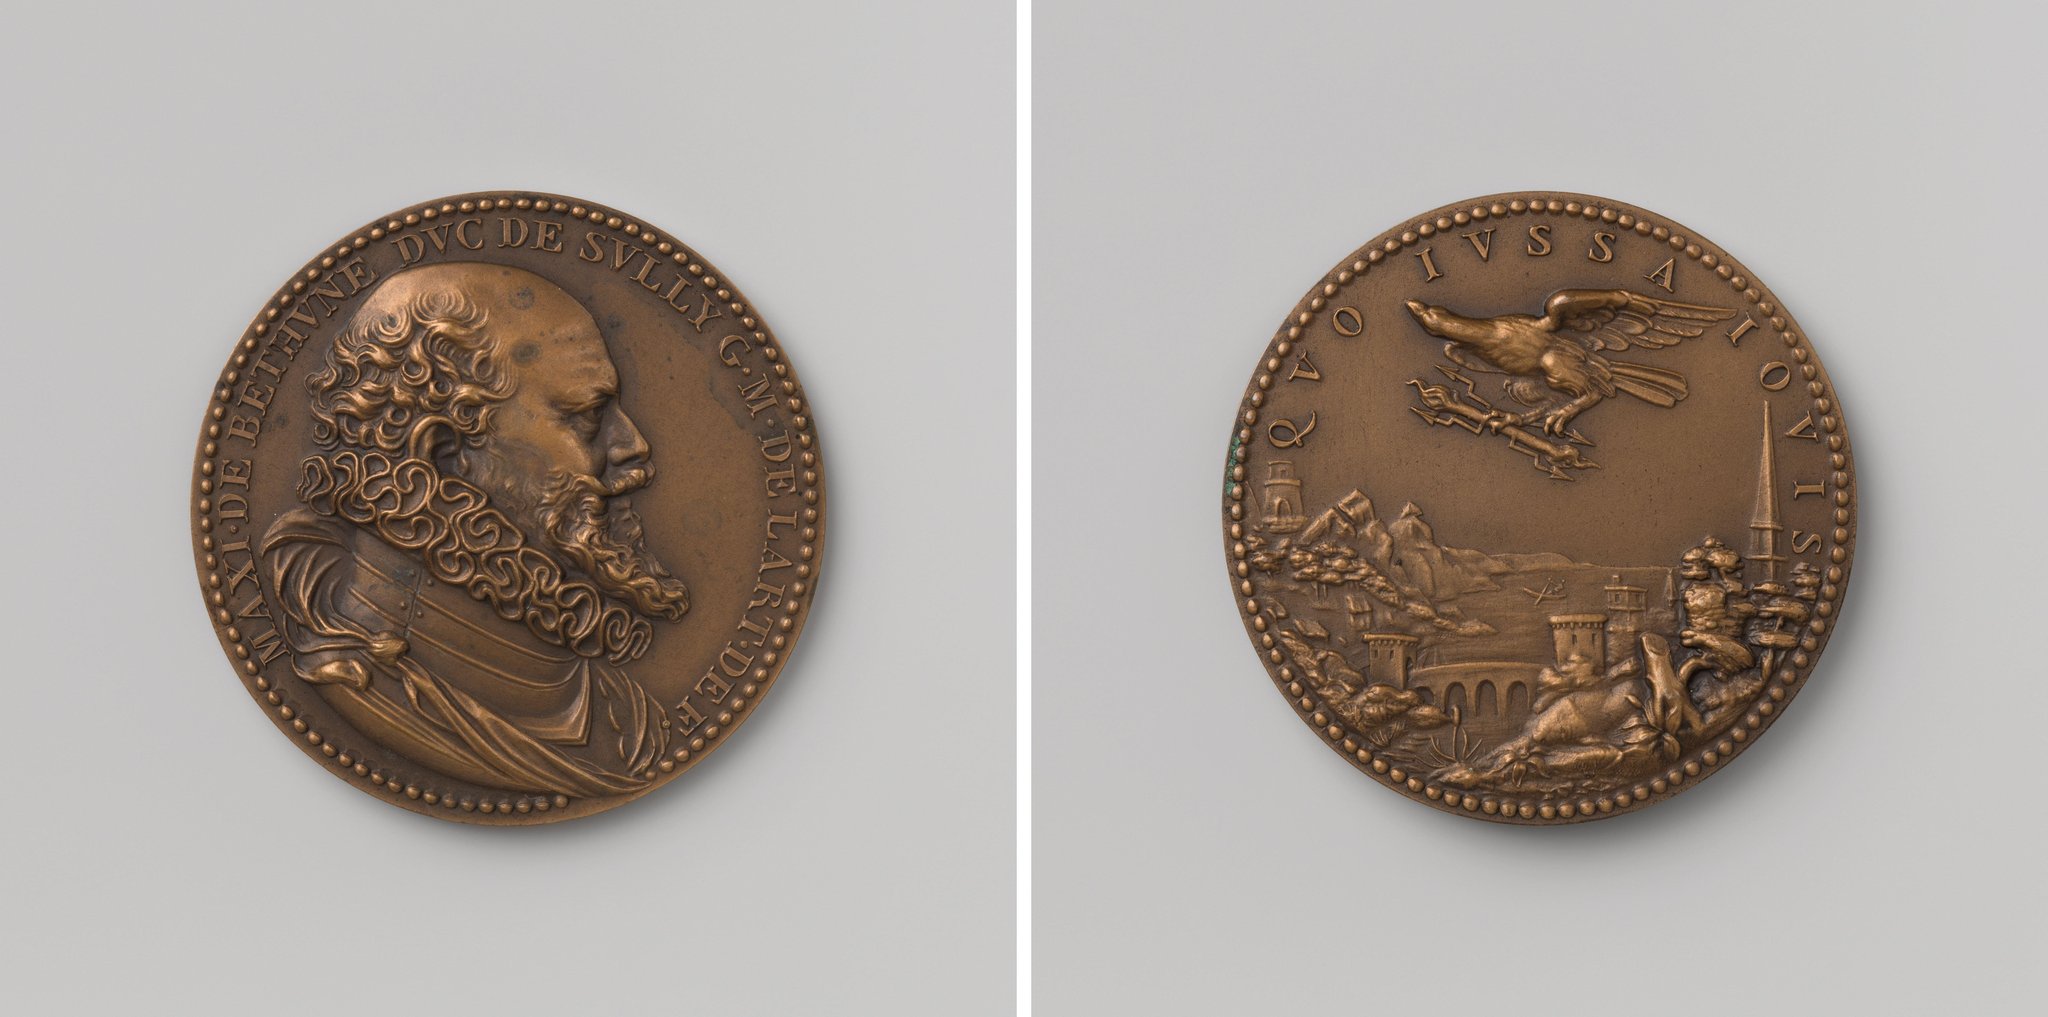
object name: copy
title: Maximilien de Bethune, hertog van Sully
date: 1607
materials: bronze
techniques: striking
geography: paris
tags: maximilien de béthune (duke of sully), historical persons, france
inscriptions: circumscription: ‘MAXI DE BETHVNE DUC DE SVLLY G.M. DE L'ART DE F.’, circumscription: ‘QVO IVSSA IOVIS’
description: Bronzen penning. Voorzijde: borststuk man, in profiel naar rechts met baard, knevel en krullend haar, bovenop kaal. Hij draagt een harnas met hoge halsberg en plooikraag en om schouders in mantel gedrapeerd binnen omschrift. Keerzijde: adelaar met donder en bliksemschichten in klauwen vliegend boven landschap met bebouwing, doorsneden door een breed water warover een brug binnen omschrift en parelrand.